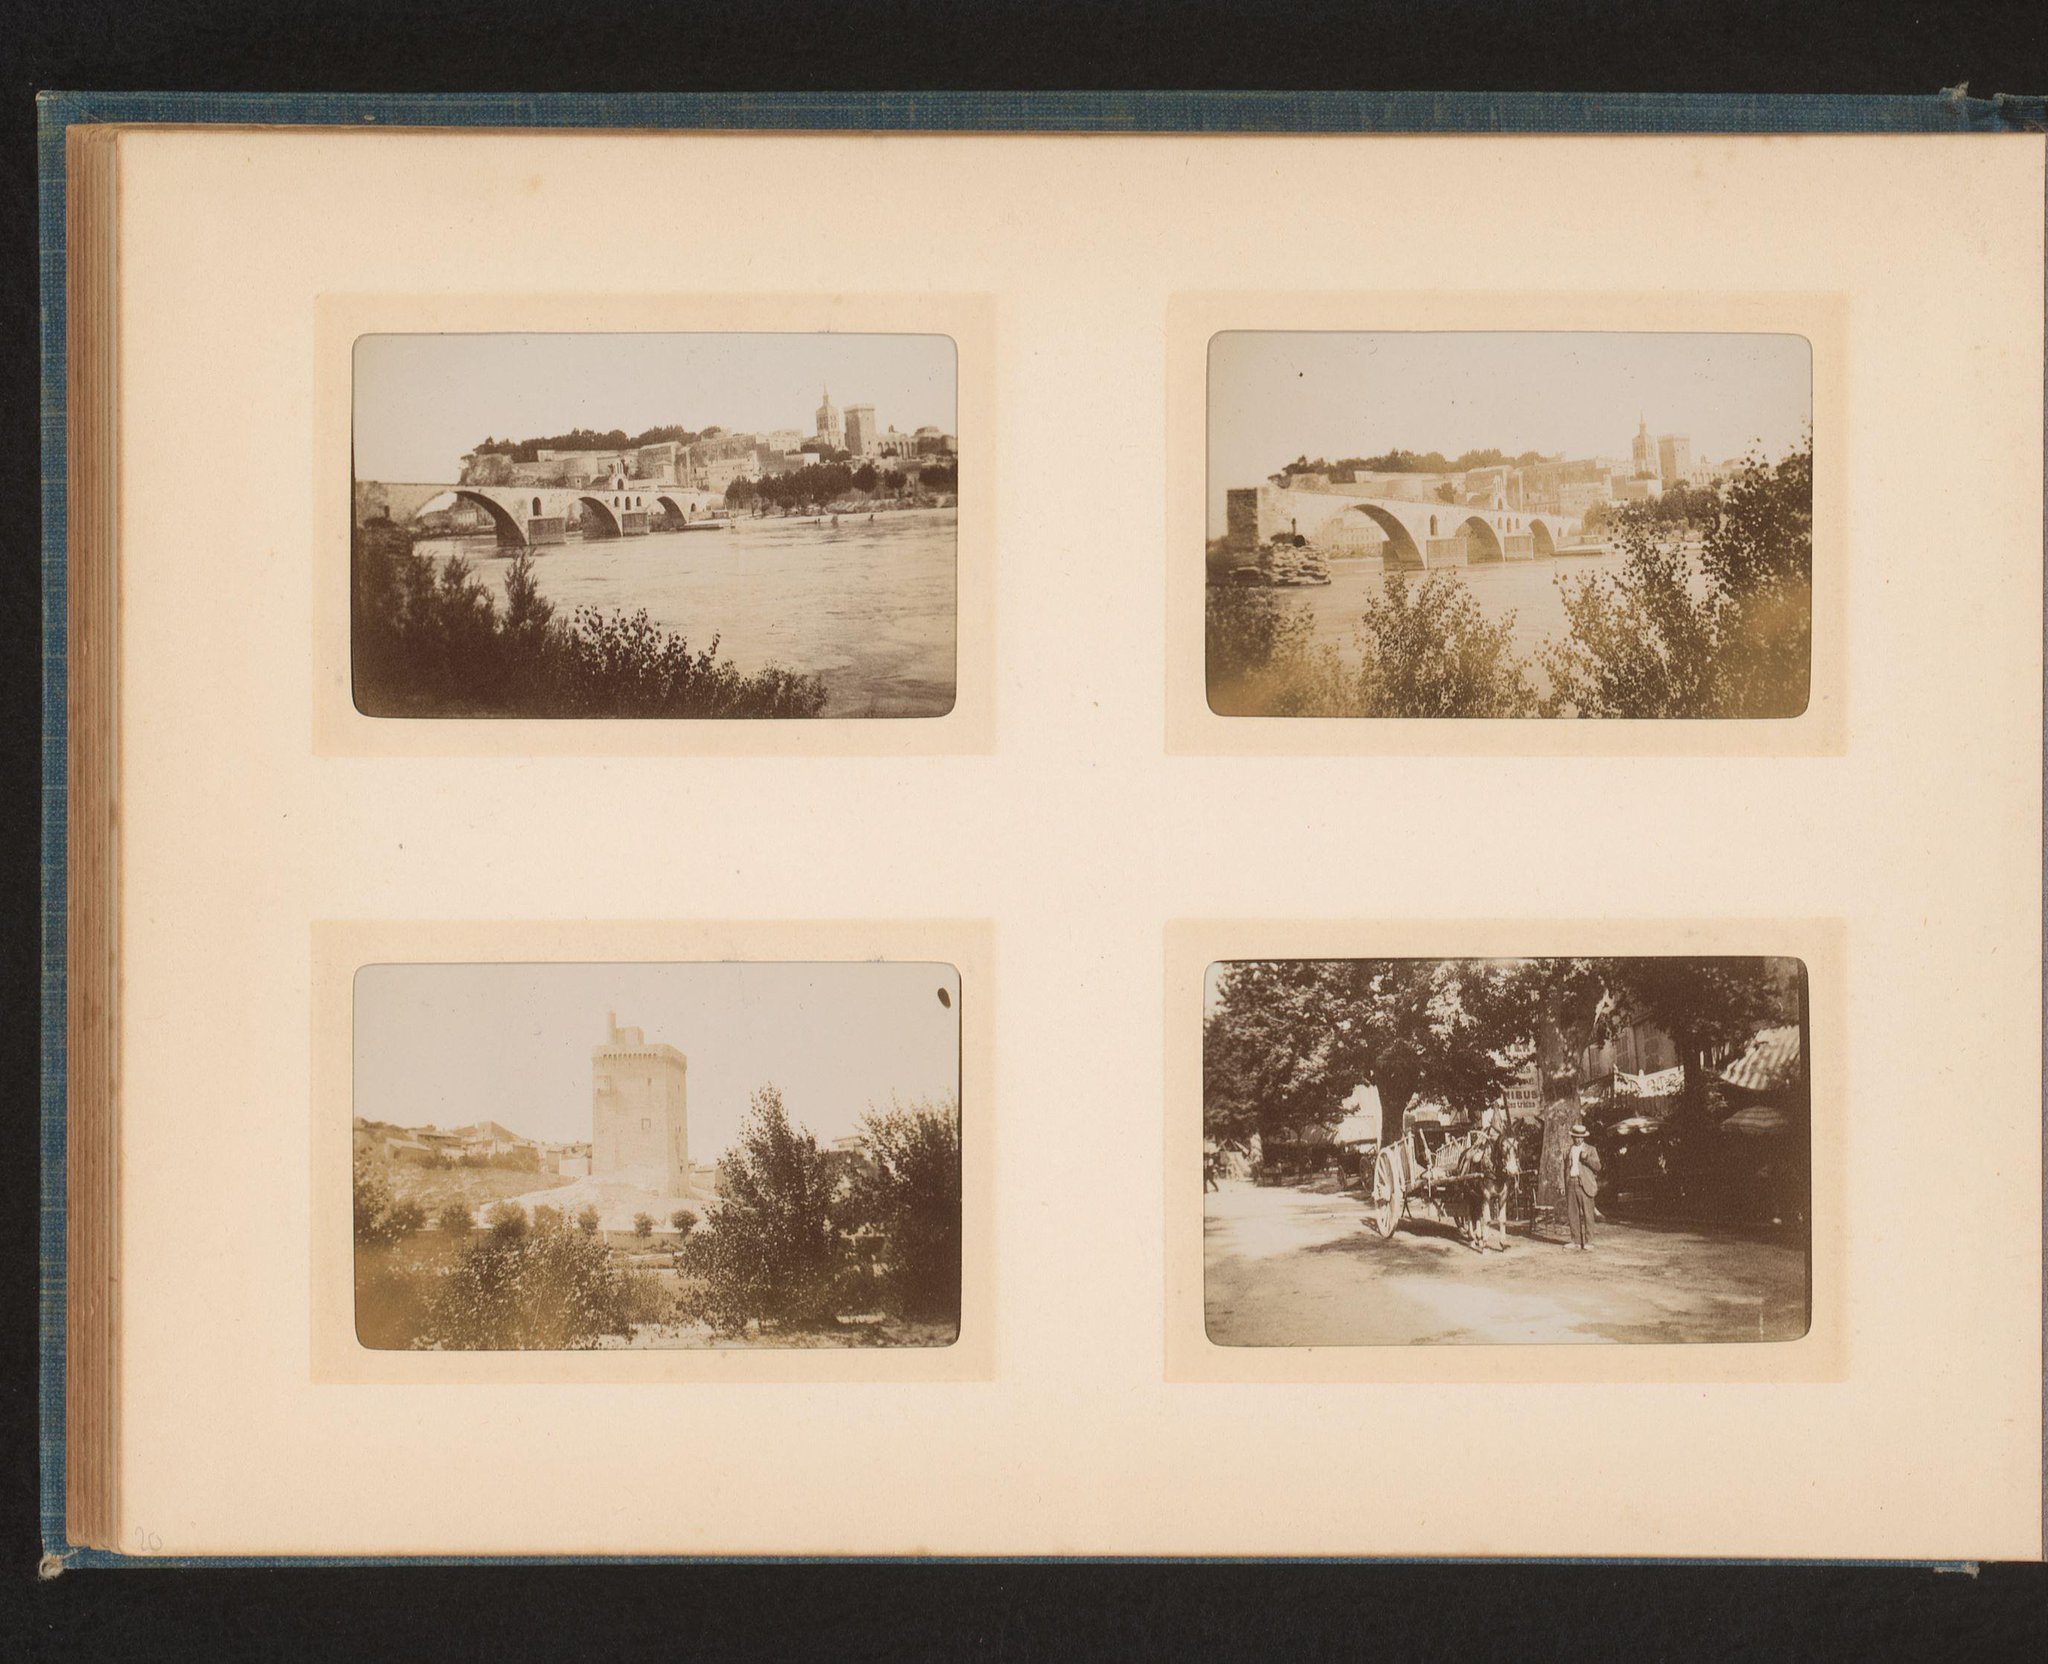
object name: album leaf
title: Twee gezichten op de Pont Saint-Bénezet, Stadsgezicht en Paardenkar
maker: Anonymous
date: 1900-1915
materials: paper, photographic support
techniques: gelatin silver print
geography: france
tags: animal traction, animal-drawn vehicle (carriage etc.), city-view in general; 'veduta', travelling; tourism, bridge, france